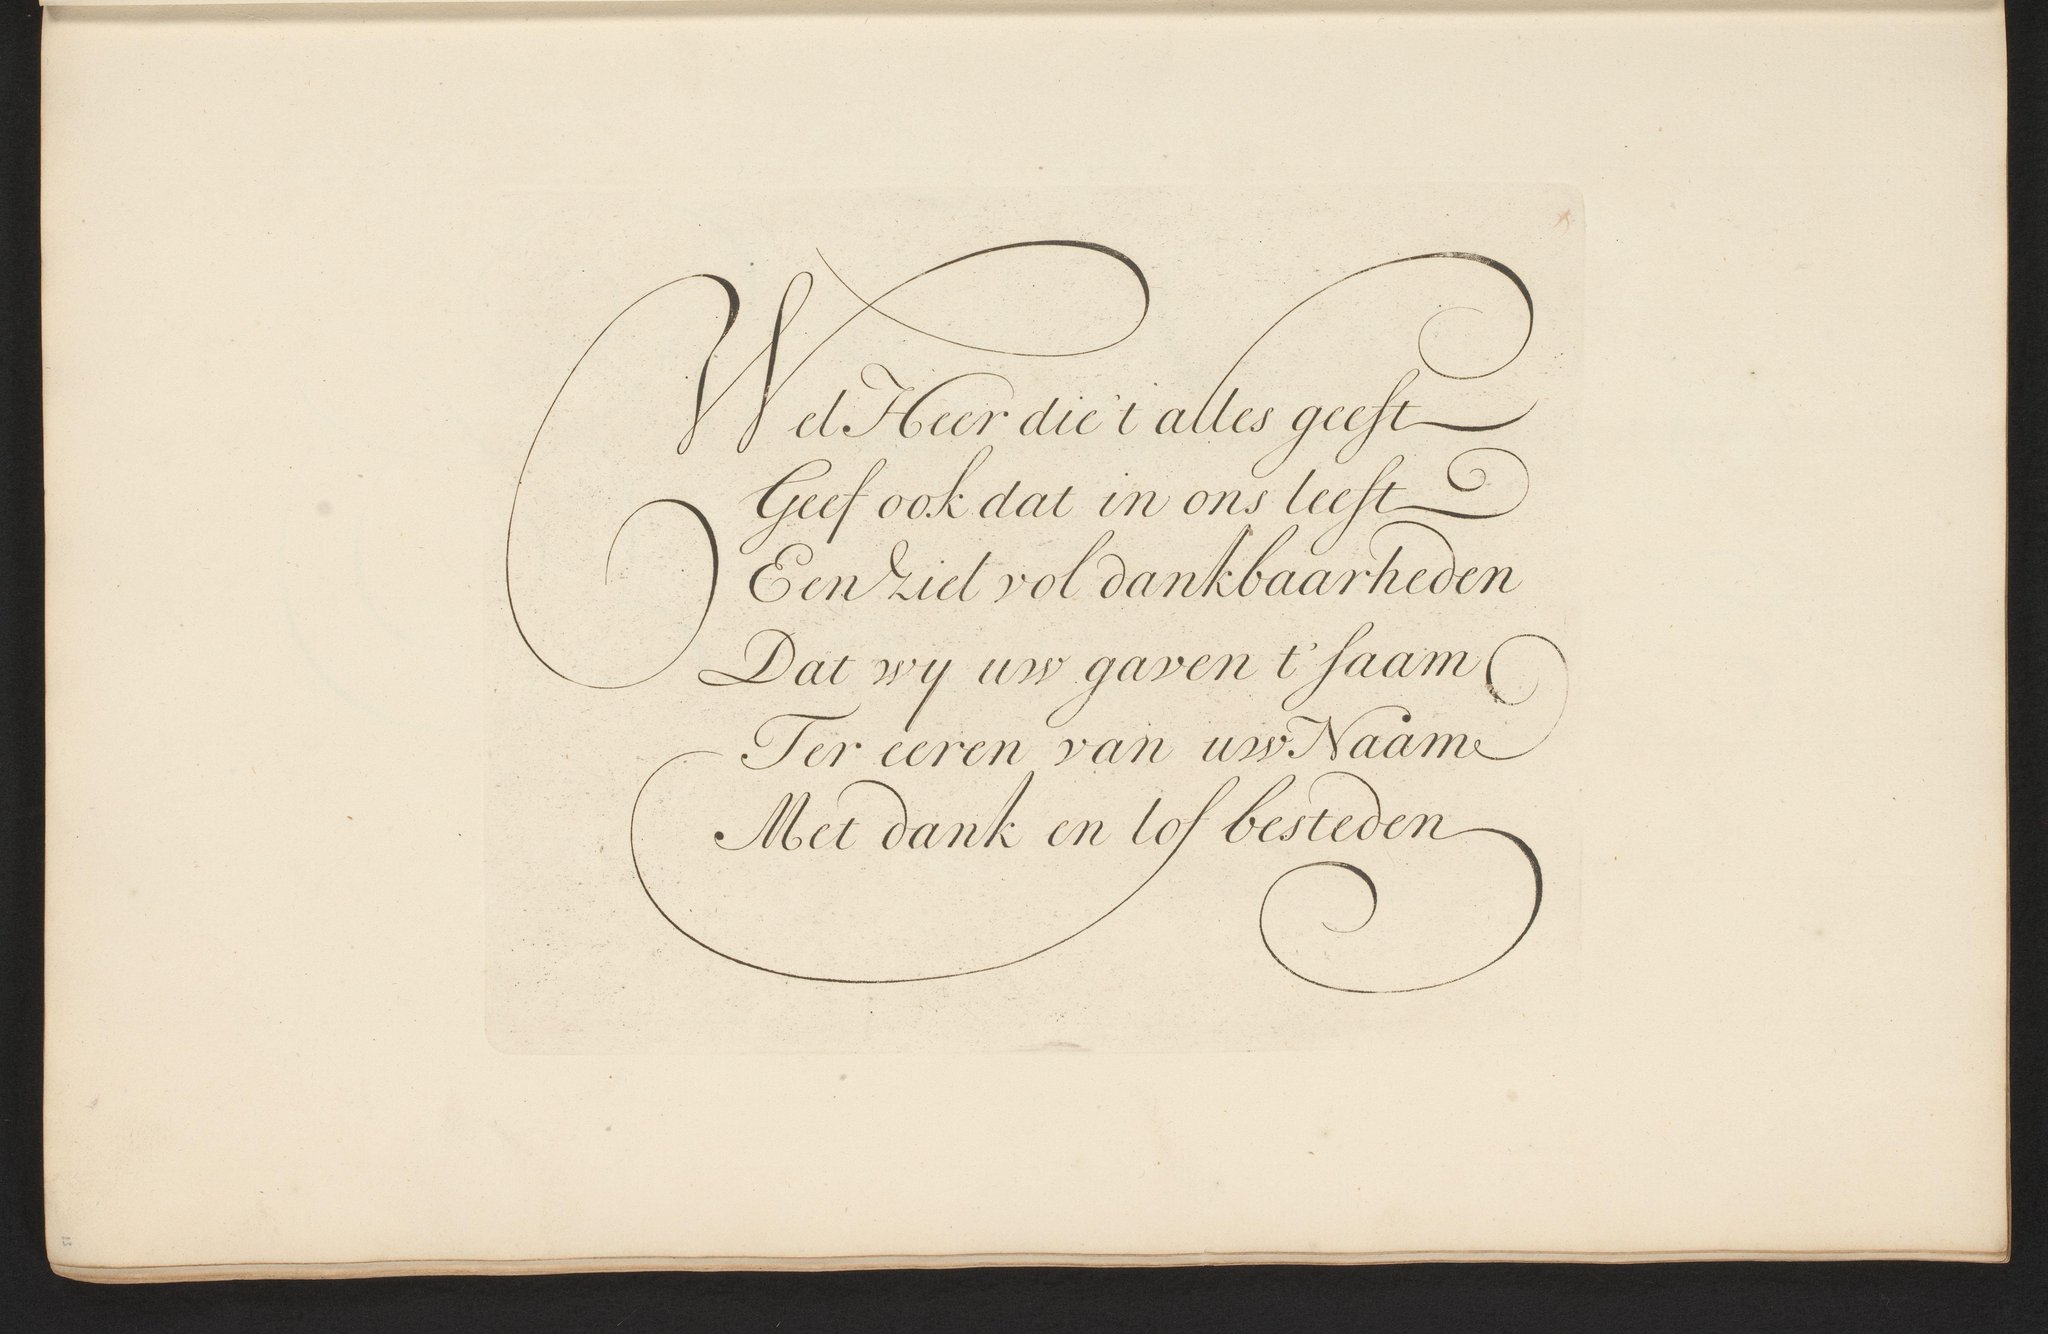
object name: album leaf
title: Schrijfvoorbeeld: Wel Heer die 't alles geeft (...)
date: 1660-1751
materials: paper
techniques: engraving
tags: calligraphy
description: Schrijfvoorbeeld met zes regels tekst in het Nederlands: Wel Heer die 't alles geeft ... De prent maakt deel uit van een album